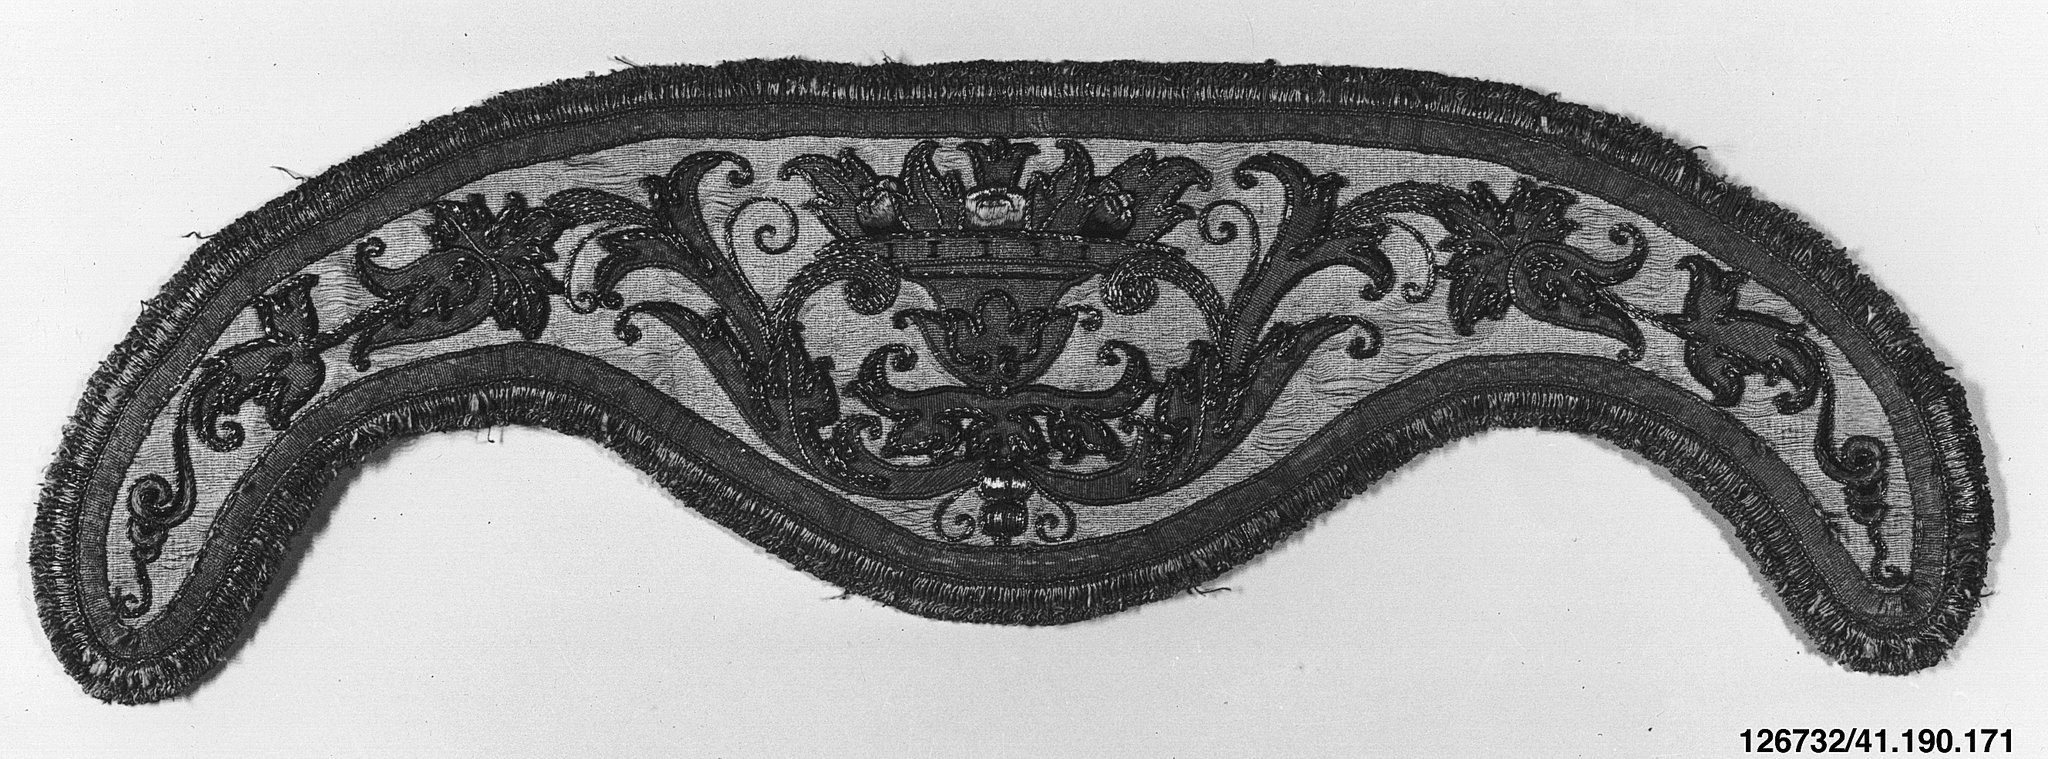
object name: amice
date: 1567-1600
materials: metal thread, silk